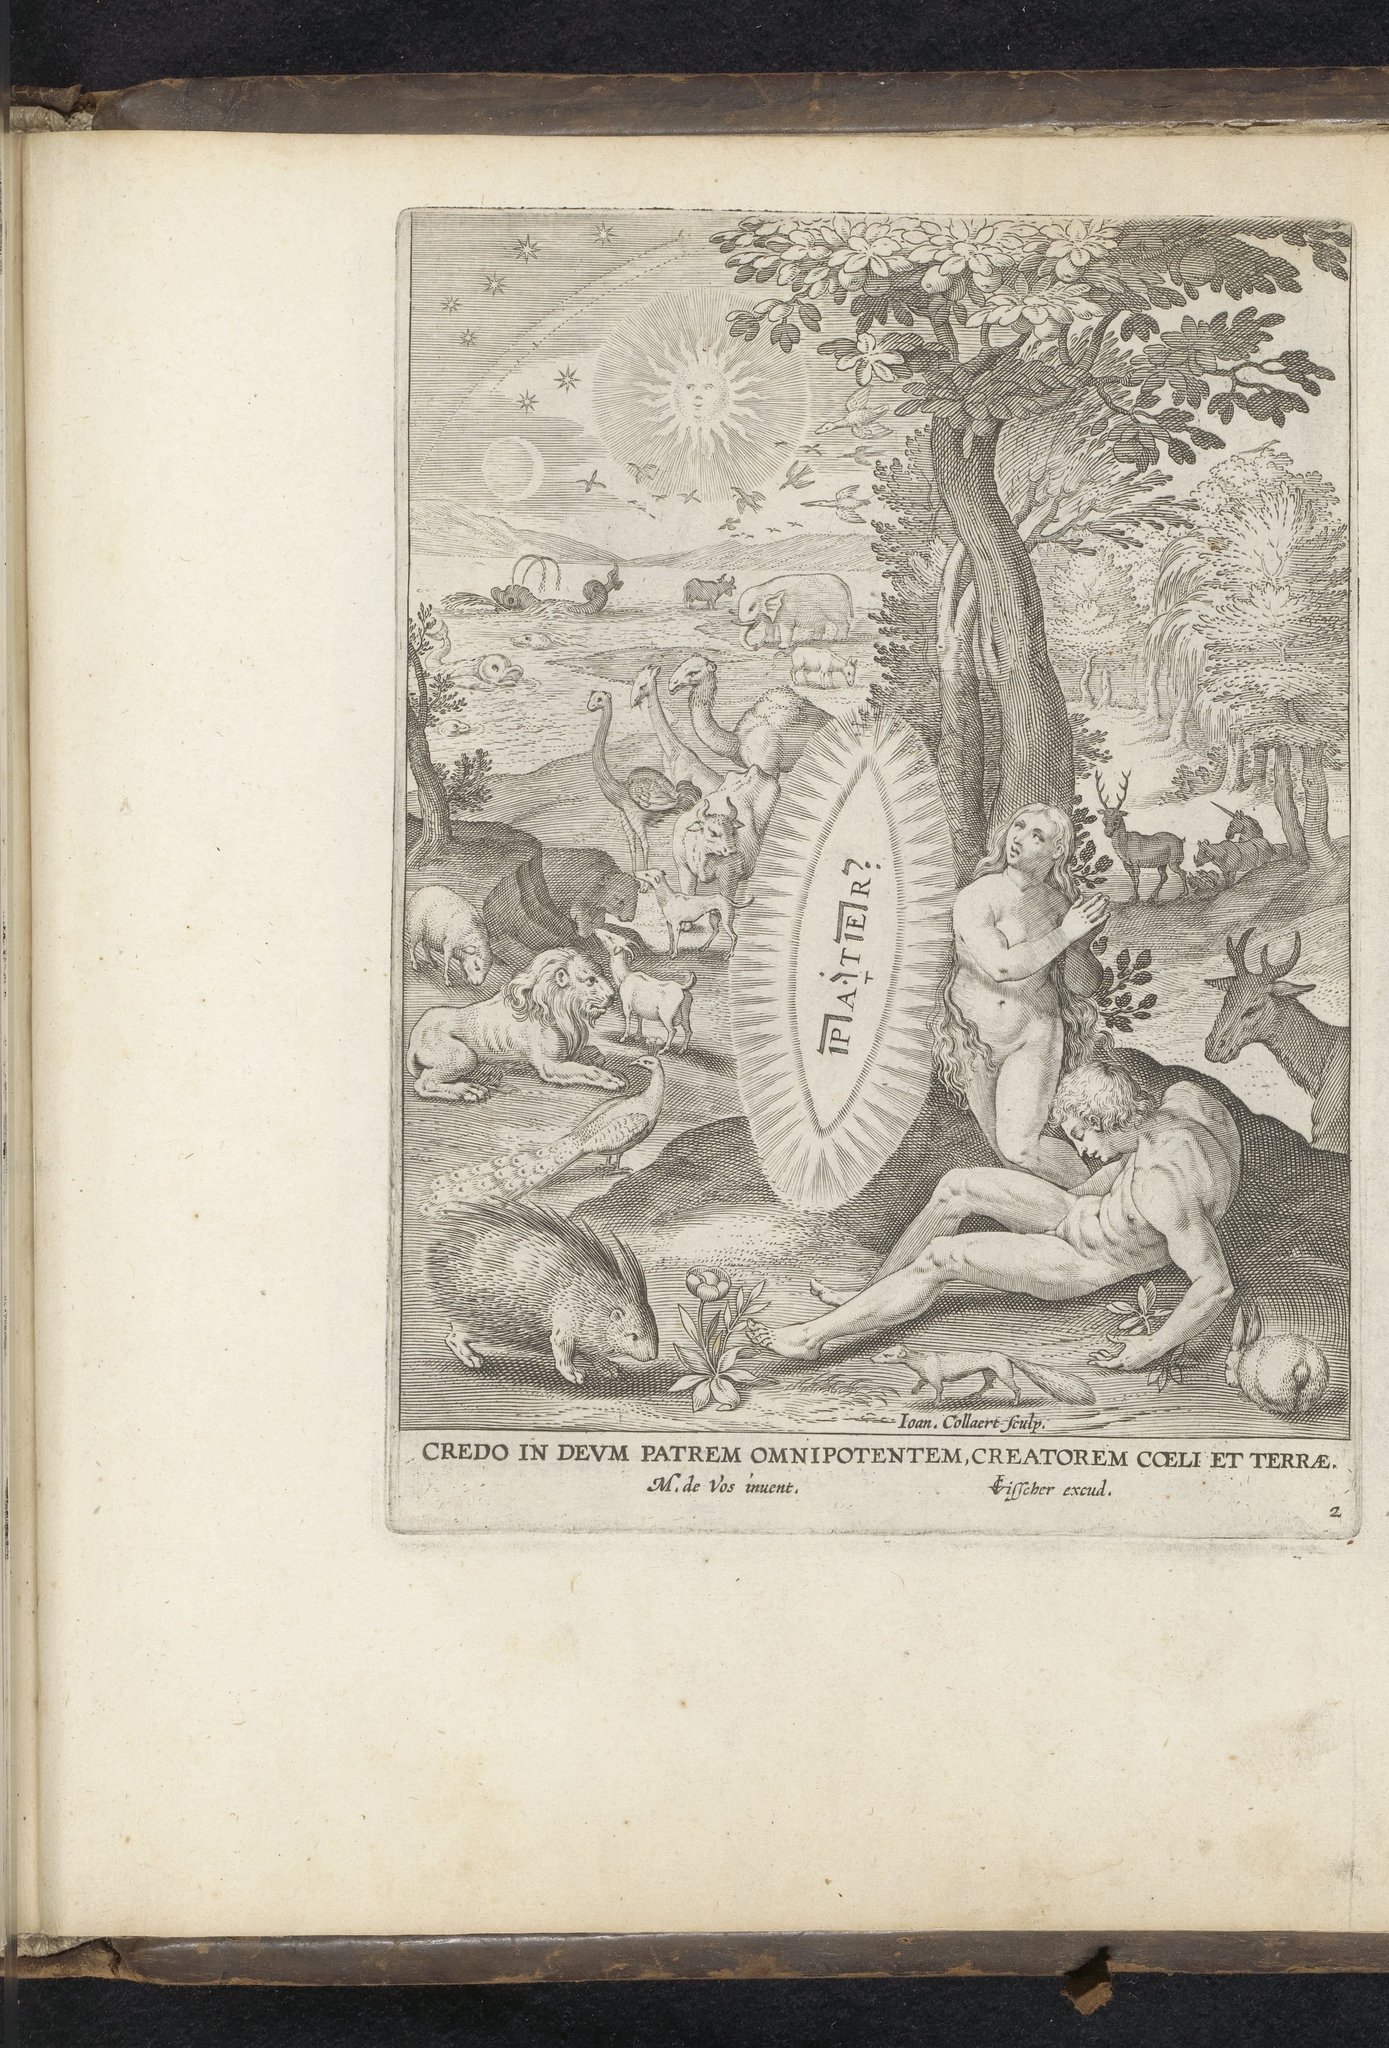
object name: album leaf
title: Schepping van Eva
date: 1570-1618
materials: paper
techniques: engraving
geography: alkmaar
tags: 'credo in deum patrem omnipotentem, creatorem coeli et terrae' ~ articles of faith, eve emerges from adam's body, the six days of creation (genesis 1:3-25)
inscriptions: number: ‘200’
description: Illustratie van het eerste geloofsartikel (Ik geloof in God, de almachtige Vader, Schepper van hemel en aarde) van de apostolische geloofsbelijdenis. God de Vader schept Eva uit Adams rib. Op de achtergrond de hele schepping. Deze prent maakt deel uit van een album.